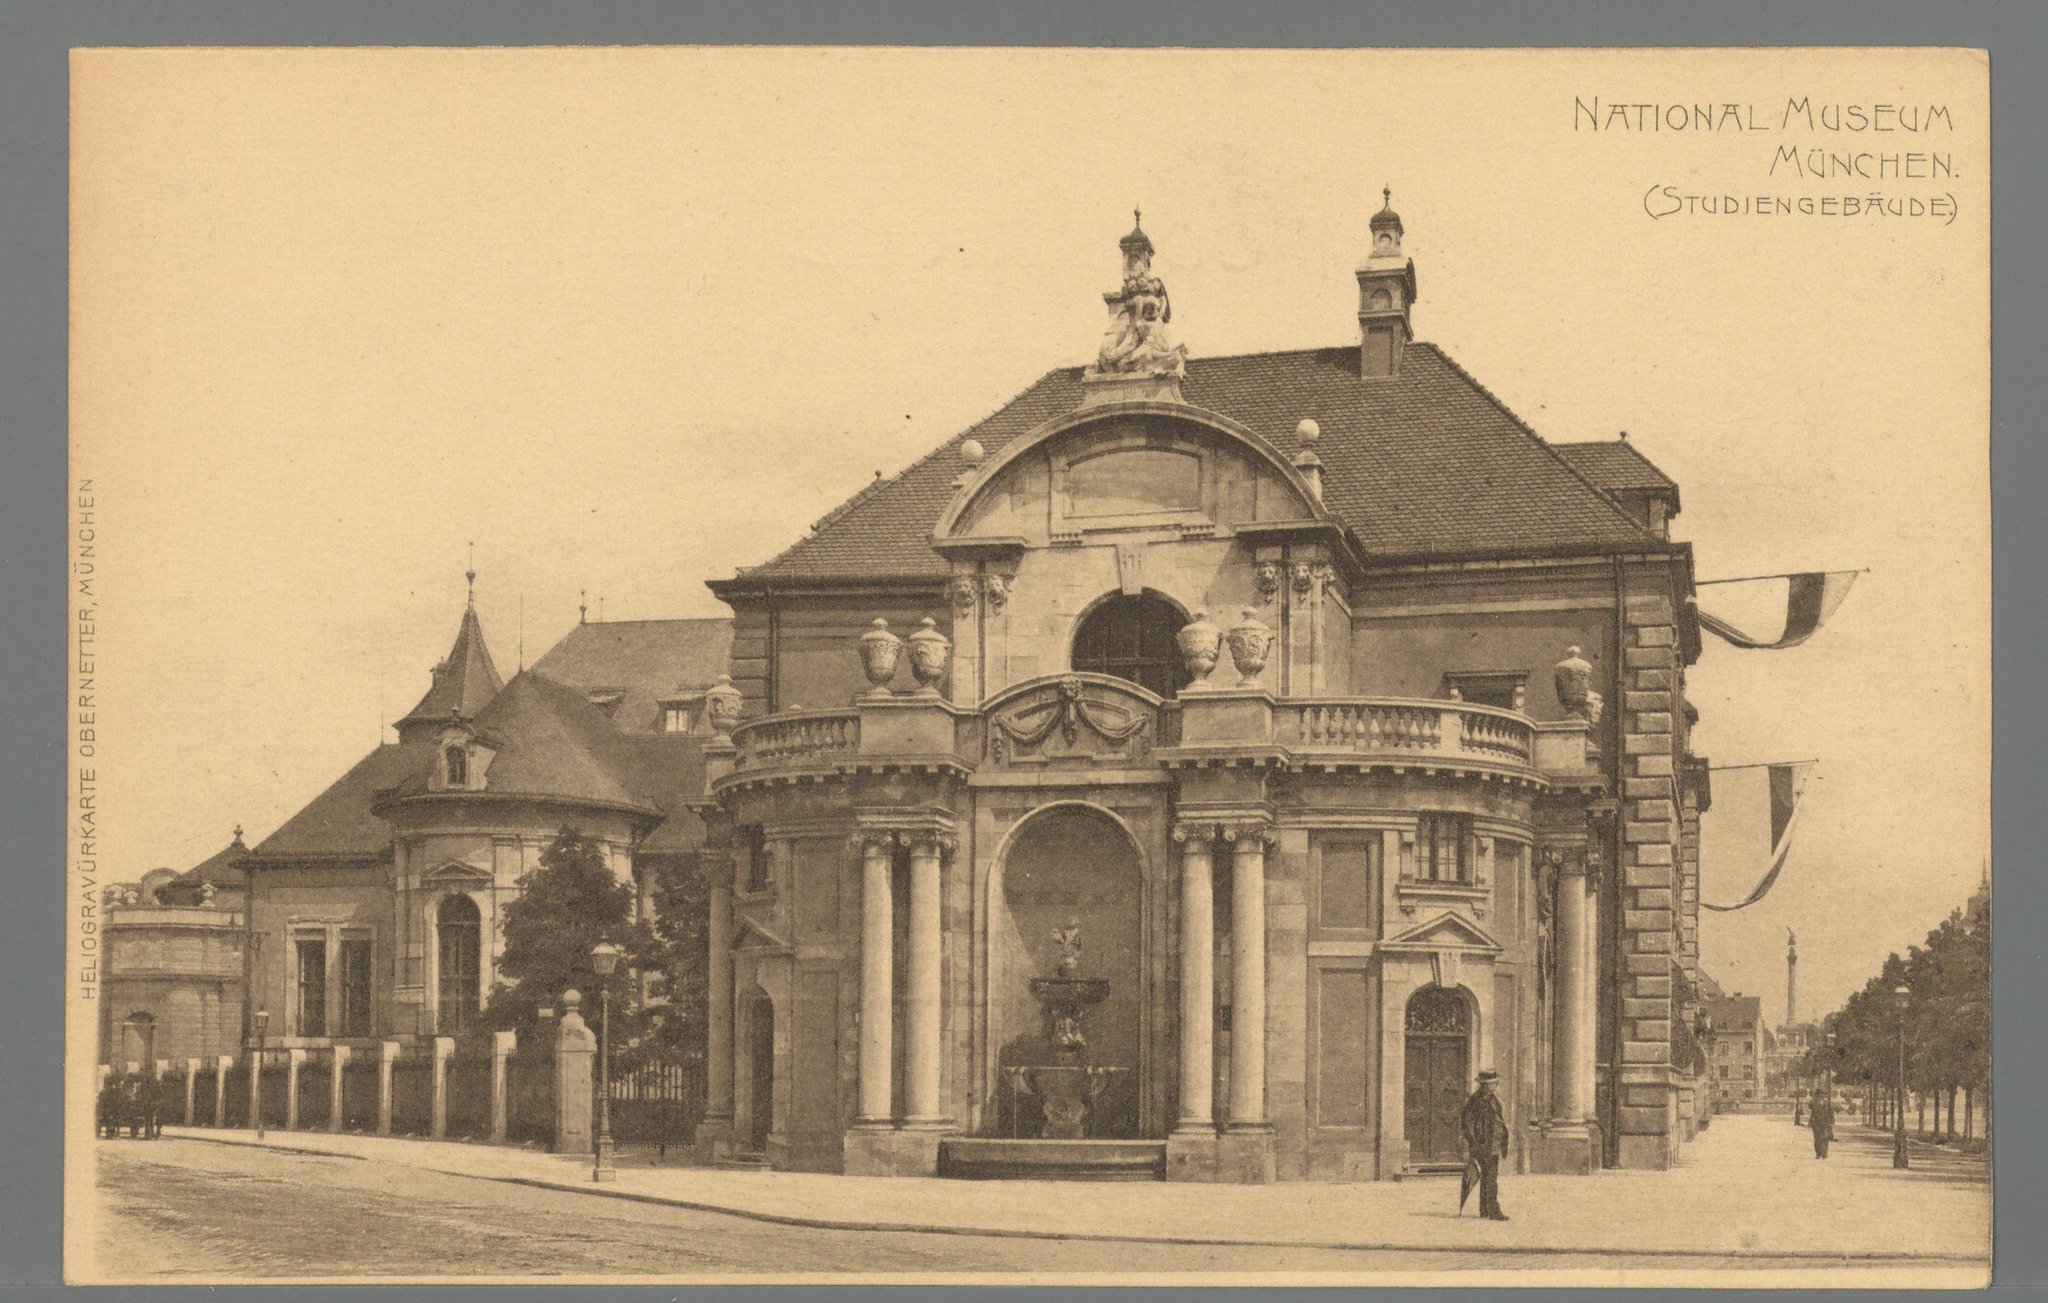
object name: photomechanical print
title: National Museum München (Studiengebäude)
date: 1885-1905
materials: cardboard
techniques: photoaquatint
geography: munich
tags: permanent exhibition, museum